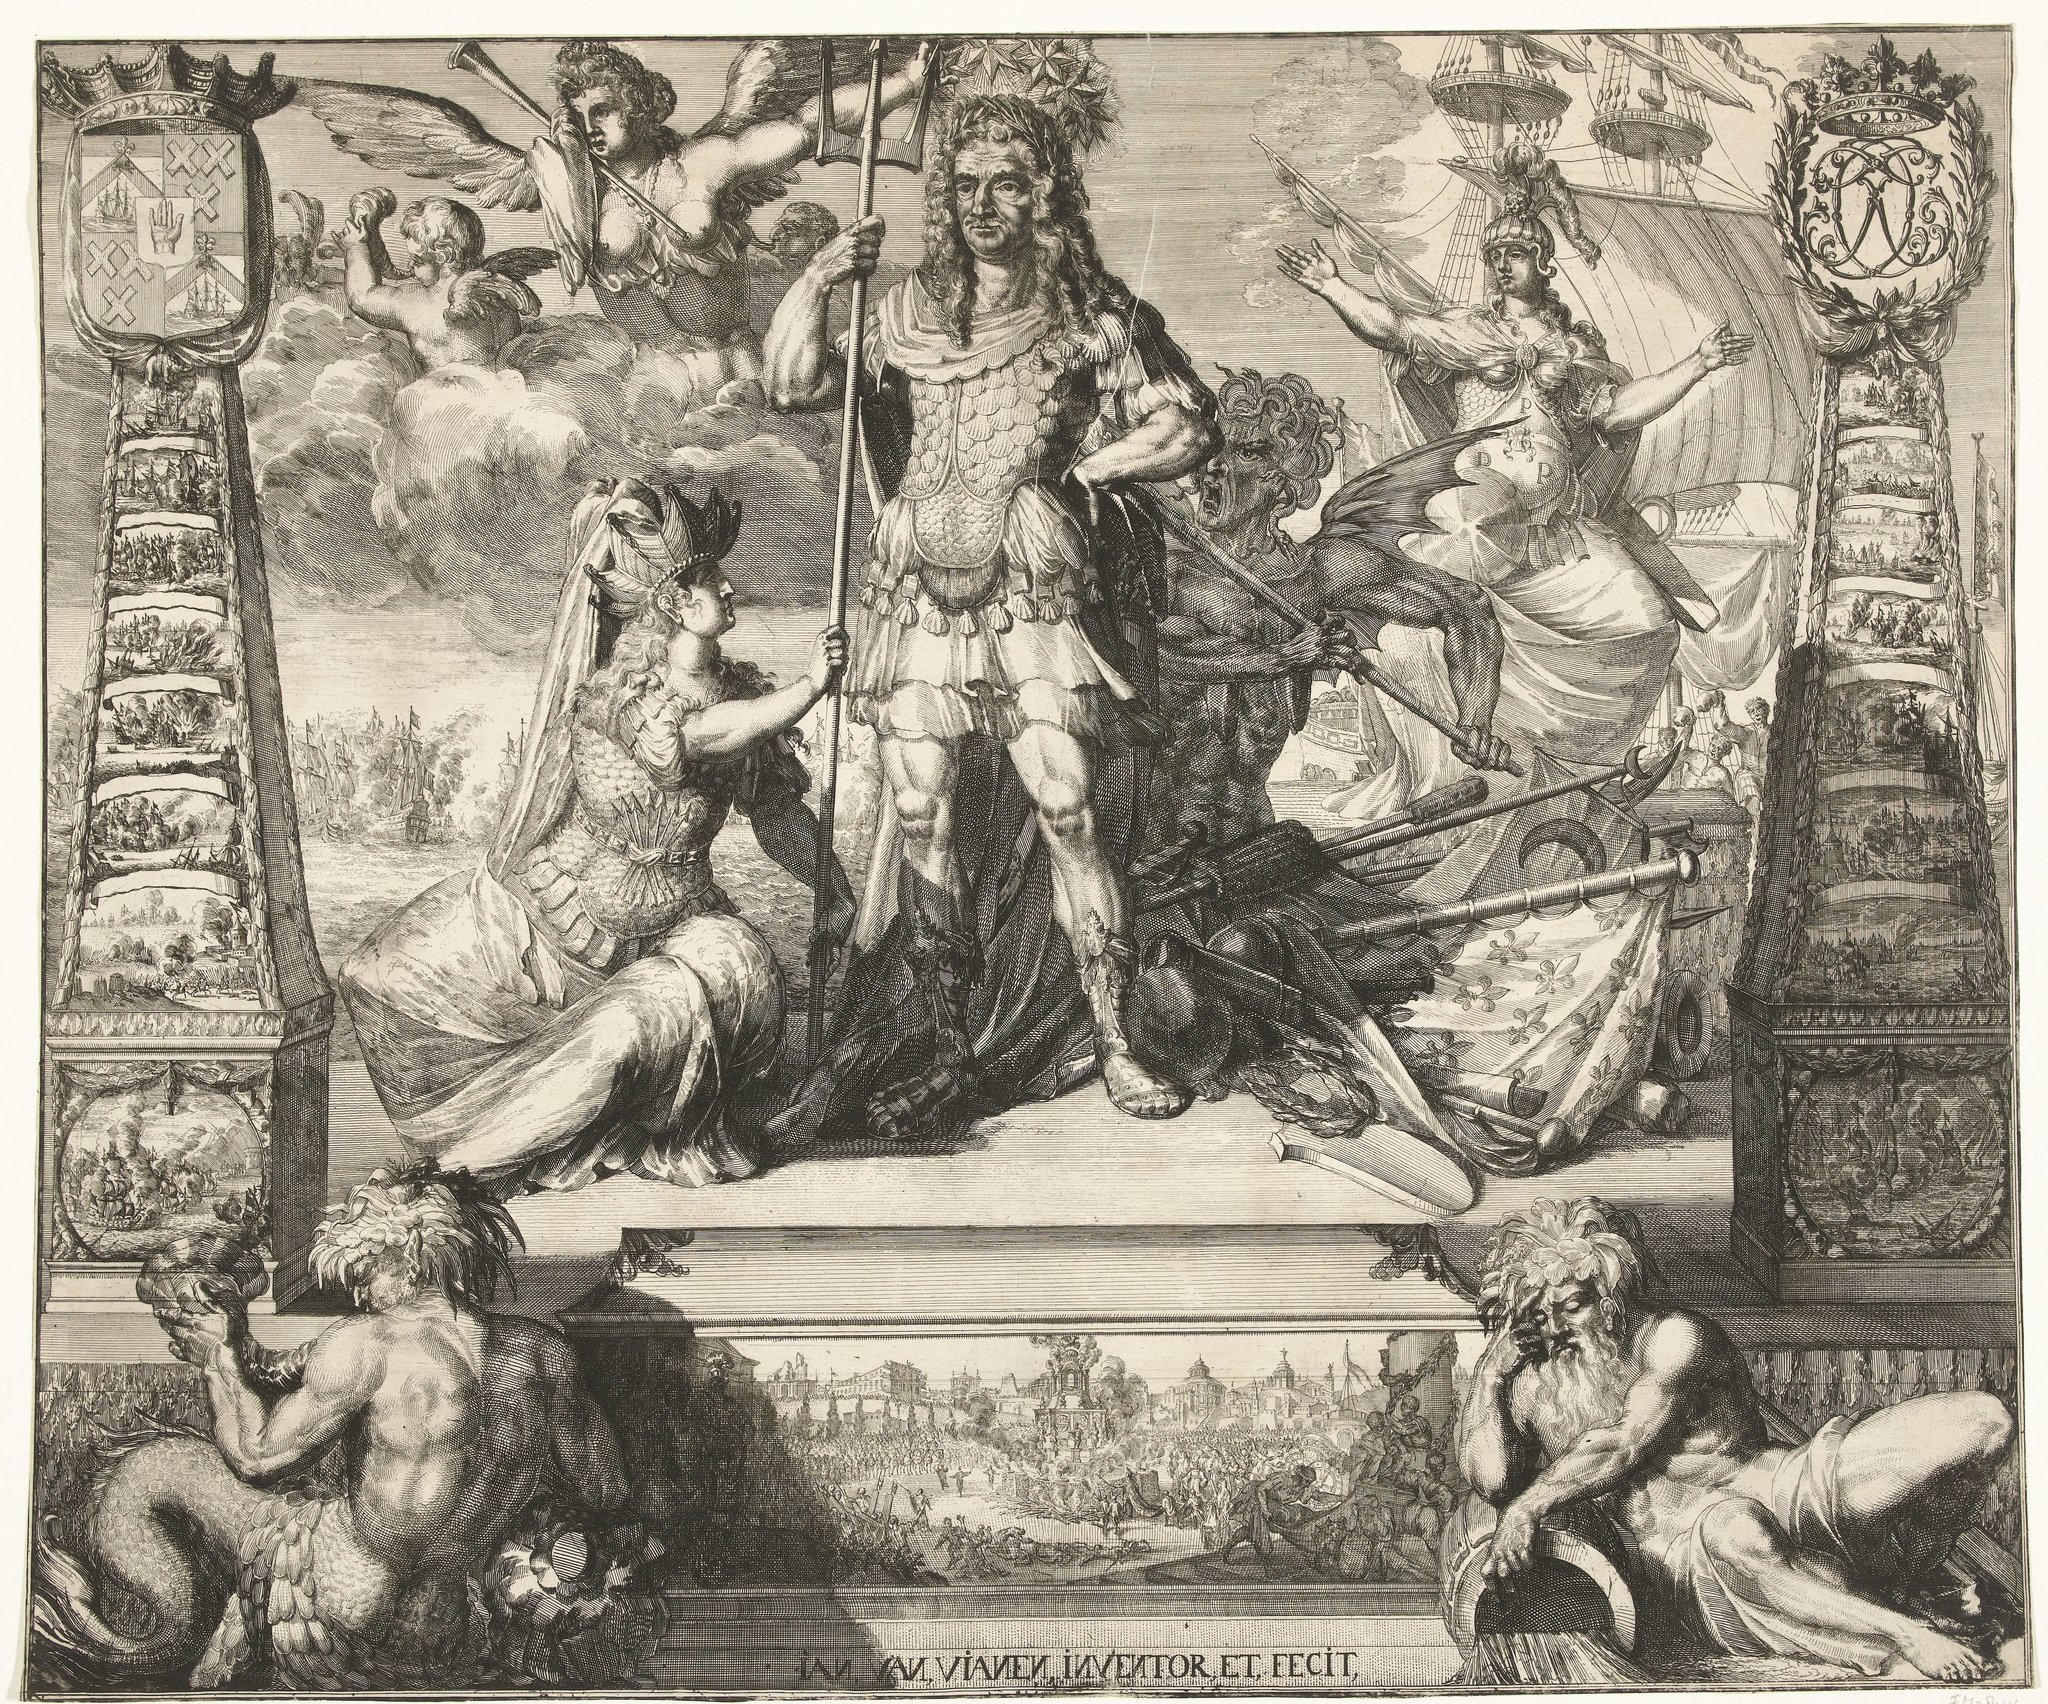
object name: print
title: Allegorie met Cornelis Tromp als Neptunus, 1691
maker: jan van vianen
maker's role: print maker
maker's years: 1660-1726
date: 1691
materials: paper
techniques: engraving, etching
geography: northern netherlands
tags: amsterdam, cornelis tromp, personifications of countries, nations, states, districts, etc., symbolic triumphs of individual persons, specific aspects, allegorical aspects of neptune; neptune as patron, fame; 'fama', 'fama buona', 'fama chiara' (ripa), netherlands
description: Allegorie ter ere van admiraal Cornelis Tromp als Neptunus, bij zijn overlijden op 29 mei 1691. Aan zijn voeten de Nederlandse Maagd met schepenkroon die hem de drietand aanreikt, achter hem de verslagen Tweedracht met slangenhaar, in de wolken de huilende Faam. Links en rechts zuilen met afbeeldingen van zeeslagen. Onderaan een riviergod en triton aan weerszijden van een romeinse lijkplechtigheid.